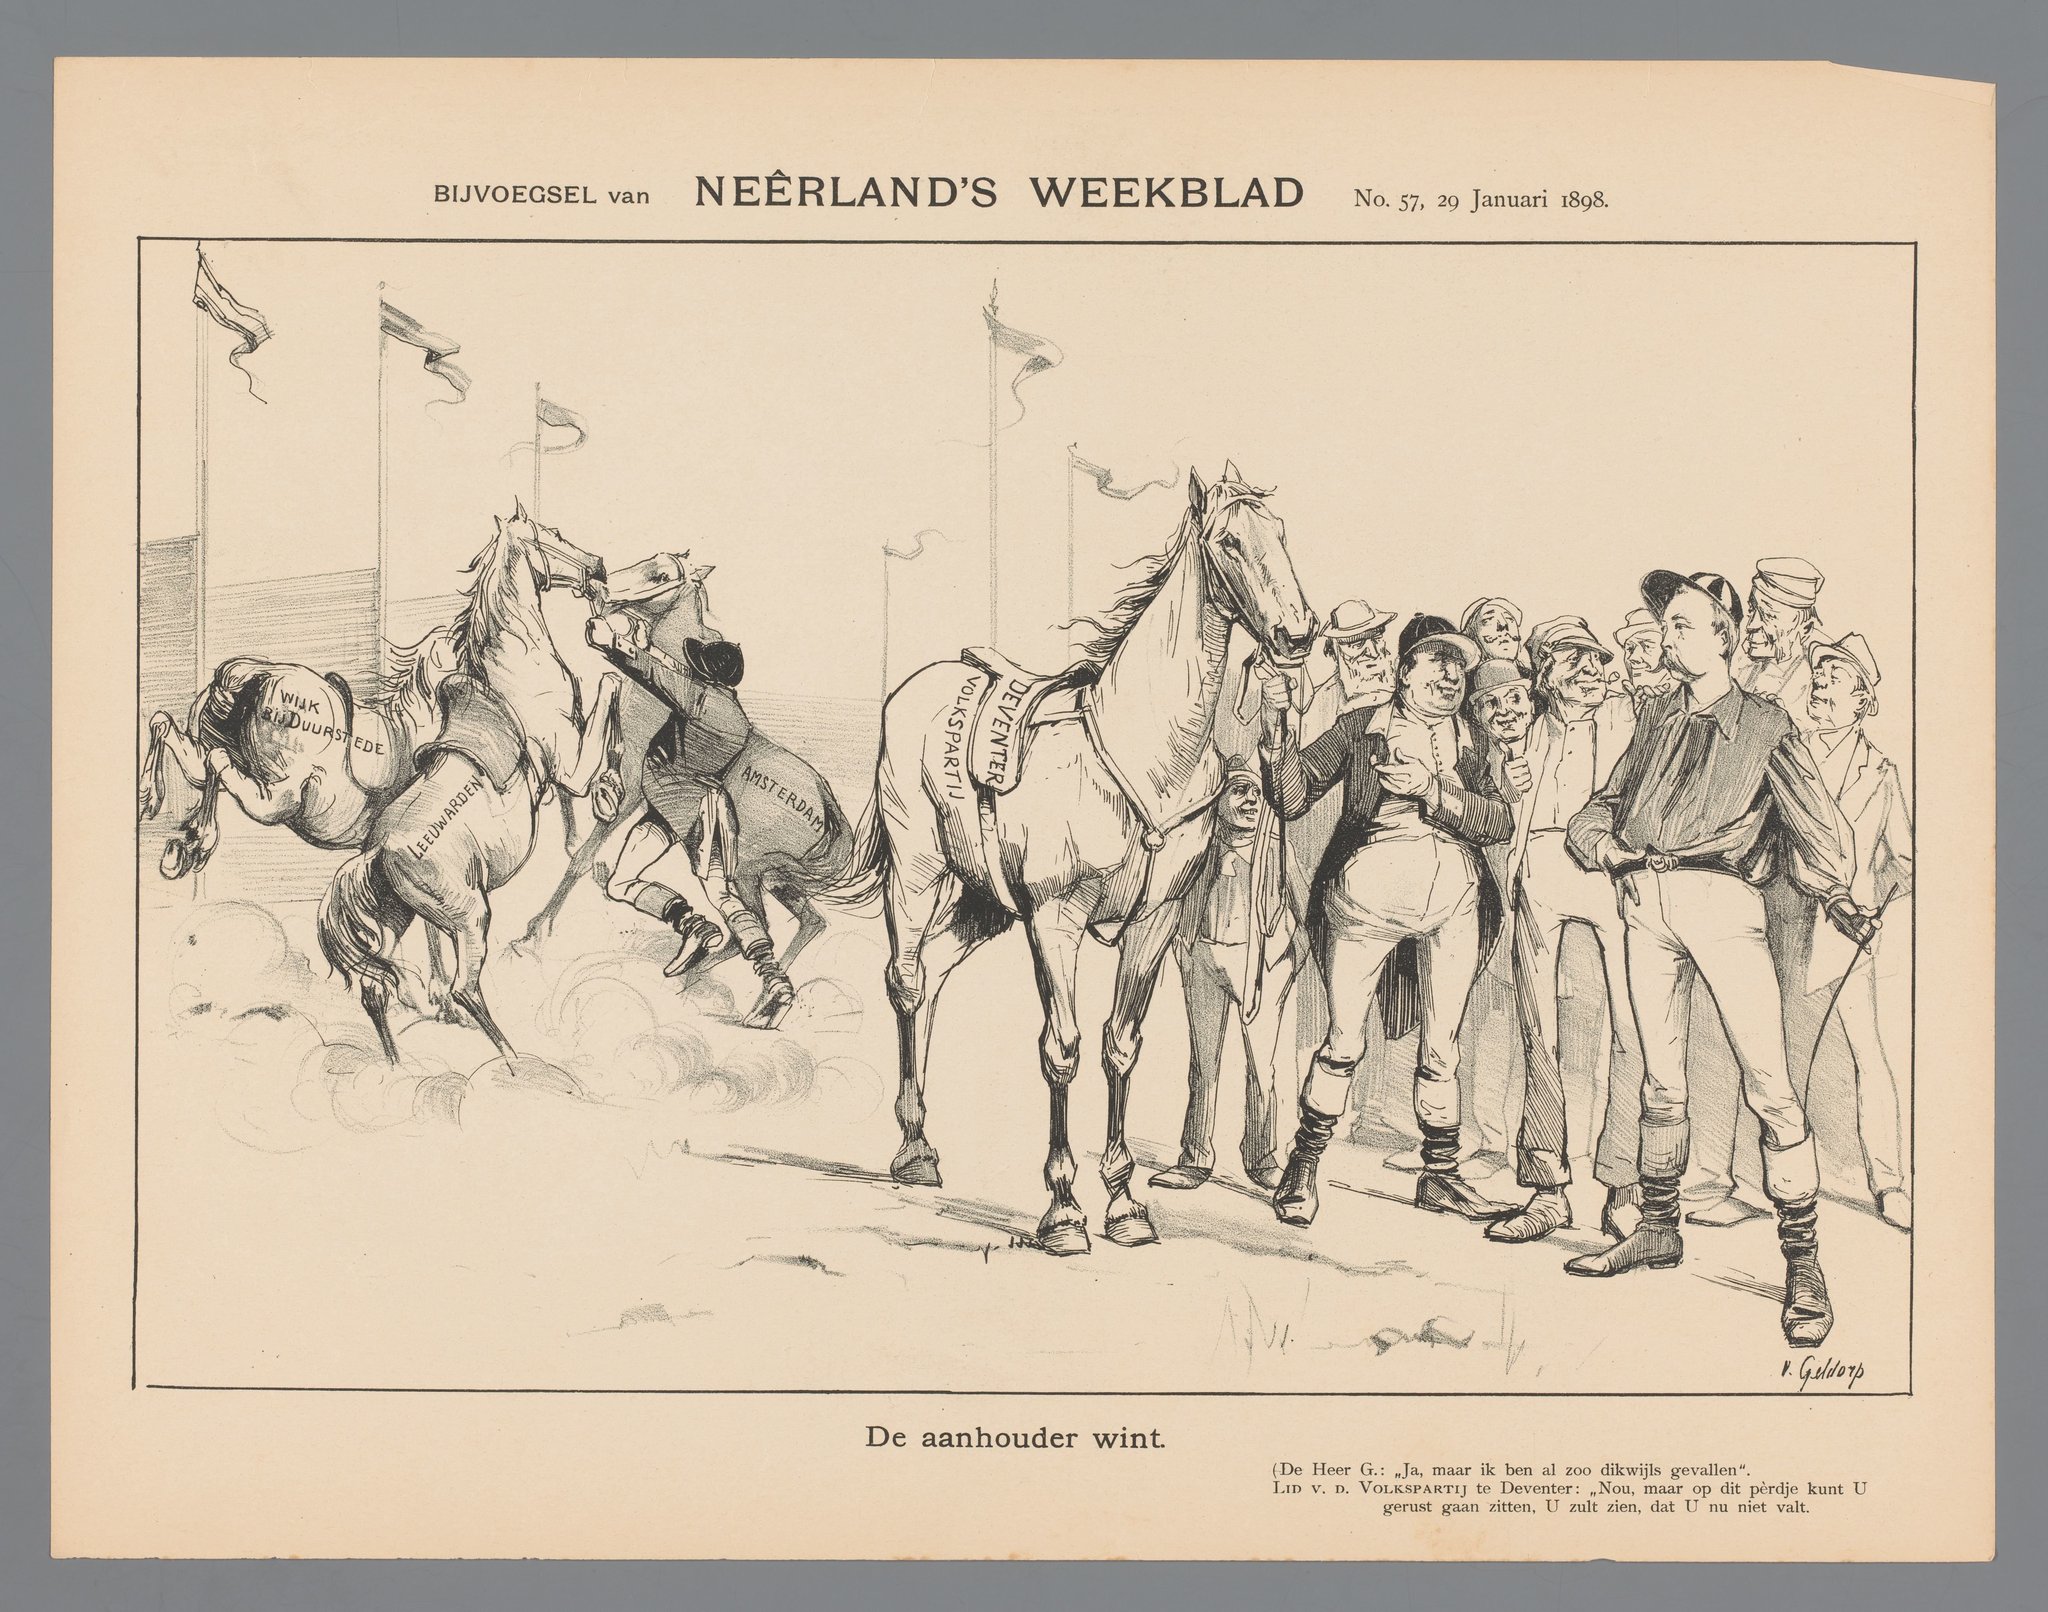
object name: cartoon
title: De aanhouder wint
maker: petrus van geldorp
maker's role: draughtsman, print maker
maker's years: 1872-1939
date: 1898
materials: paper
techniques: lithograph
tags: horse-racing, political caricatures and satires, deventer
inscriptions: date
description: Prent uit het bijvoegsel van: Neêrland’s Weekblad, nr. 57, 29 januari 1898.